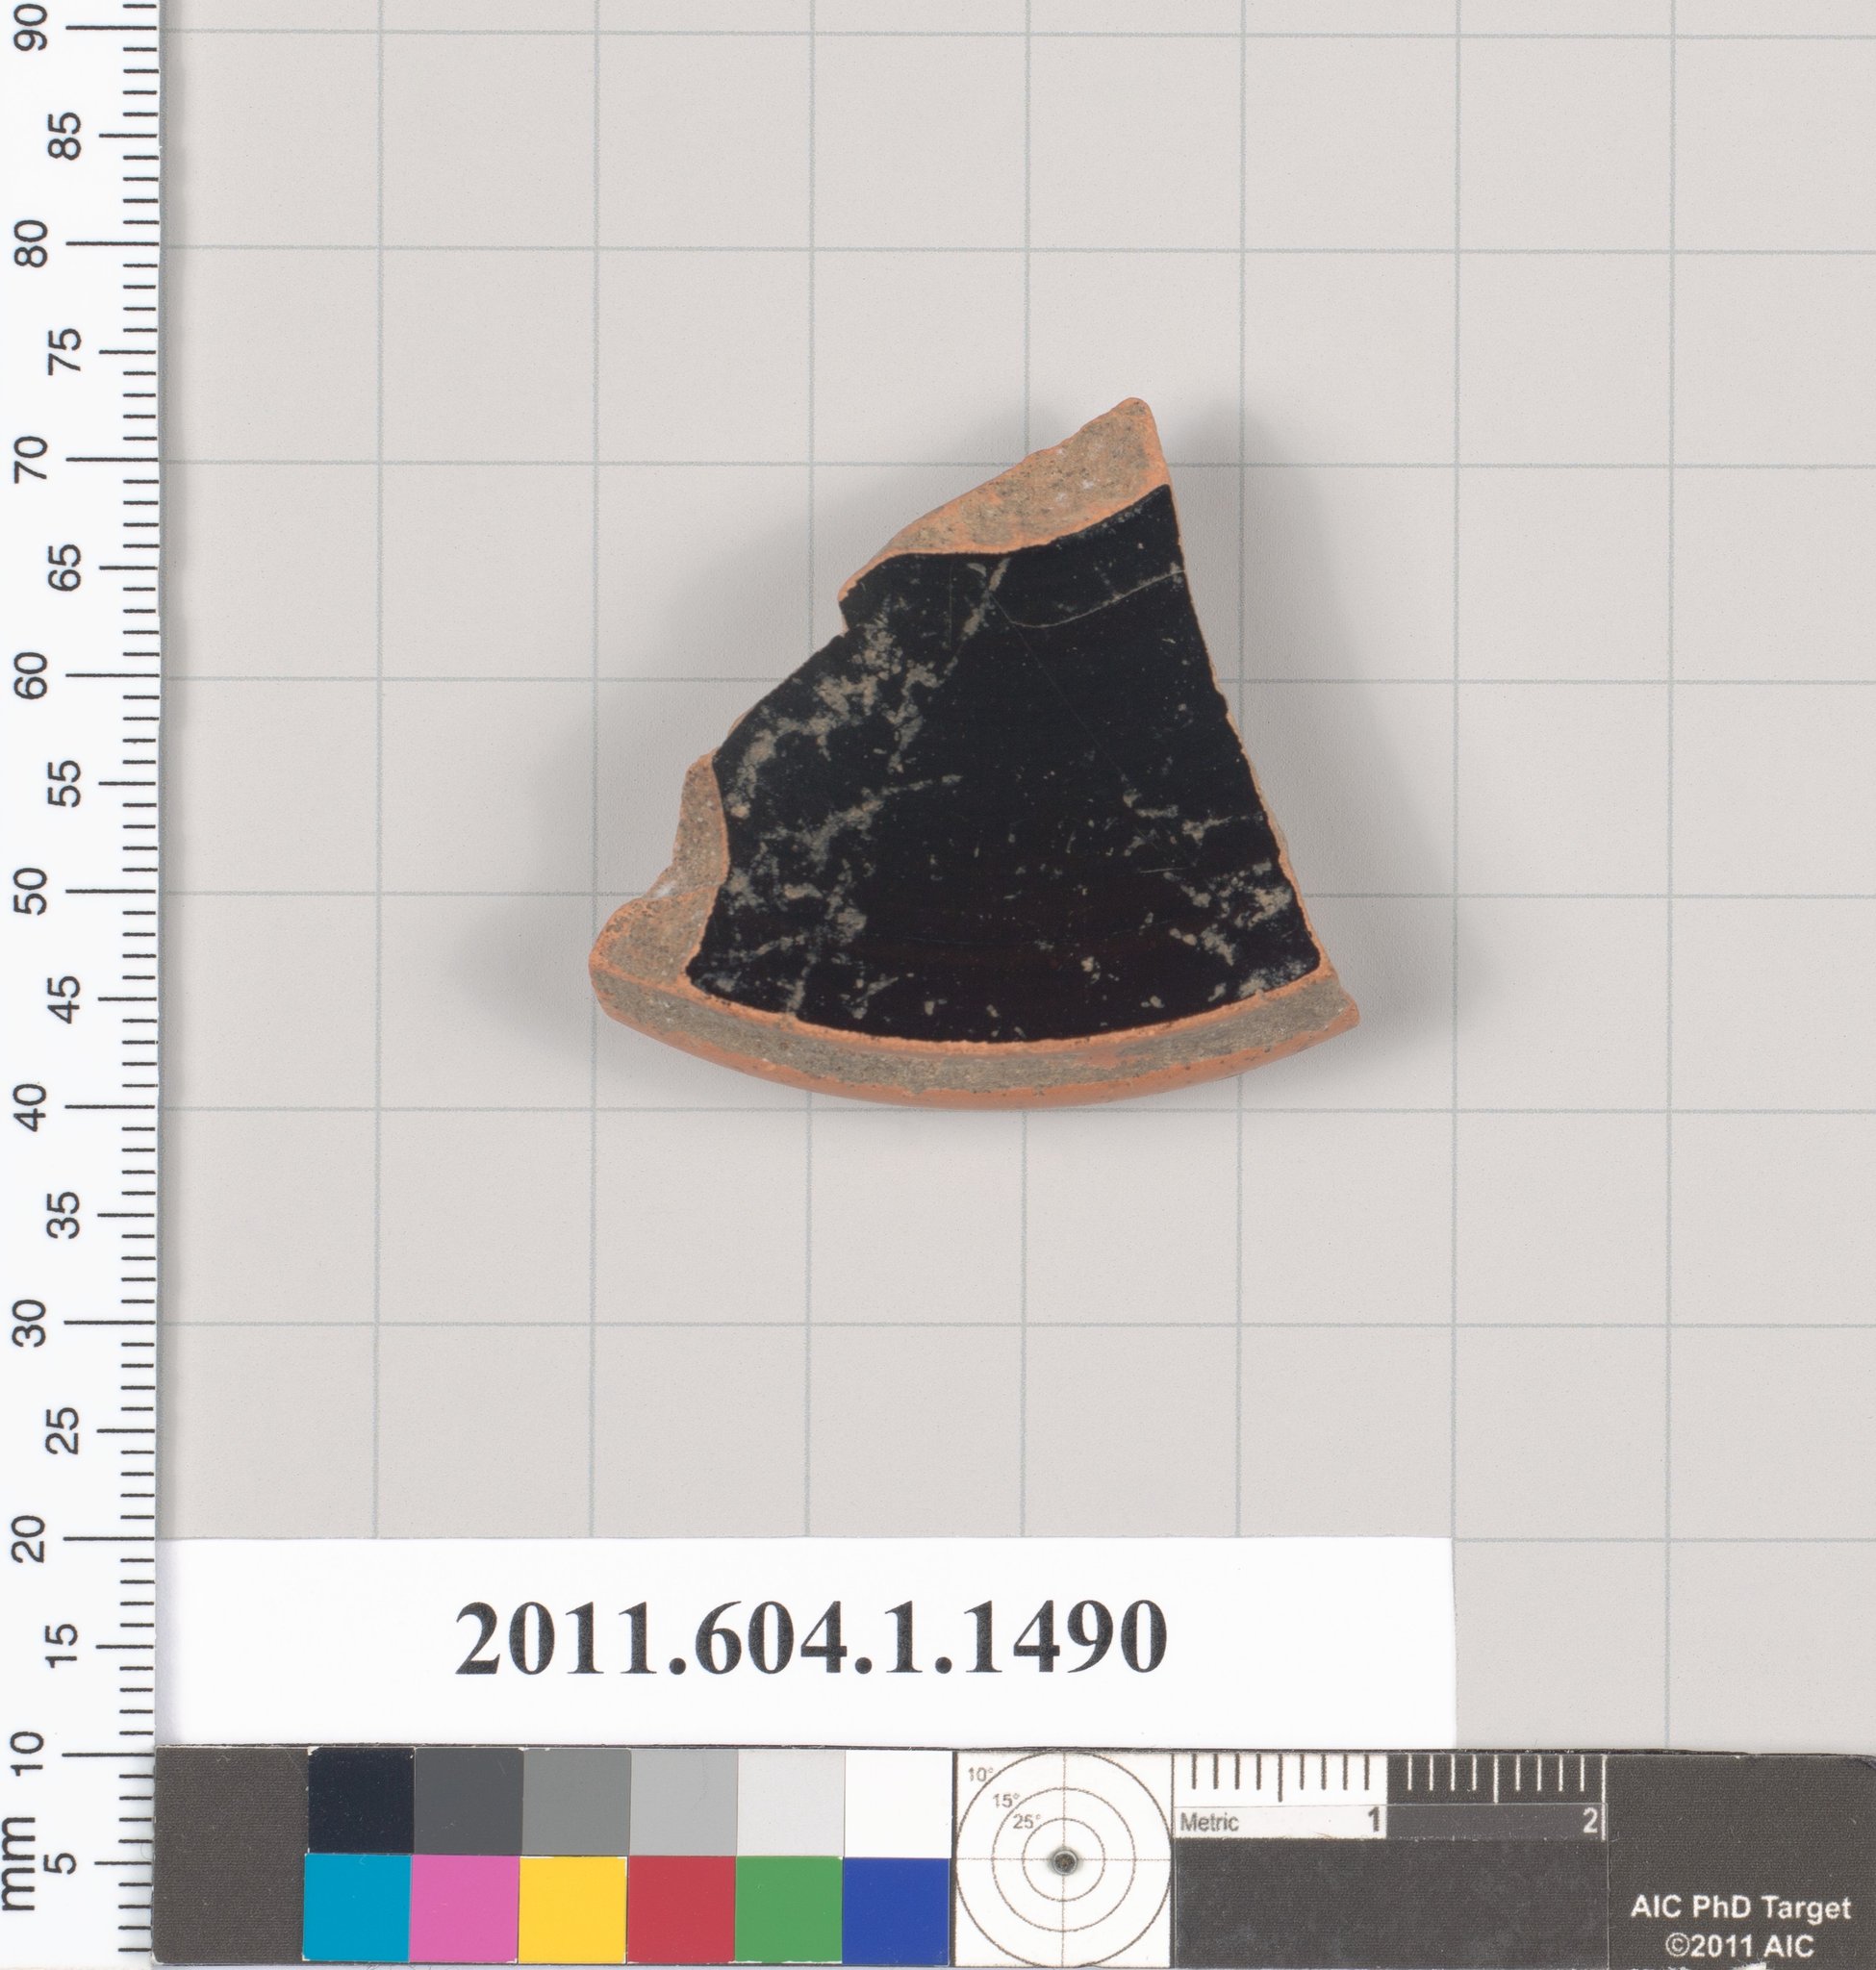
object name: kylix fragment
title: Terracotta fragment of a kylix (drinking cup)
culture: greek, attic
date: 500-401 BCE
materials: terracotta